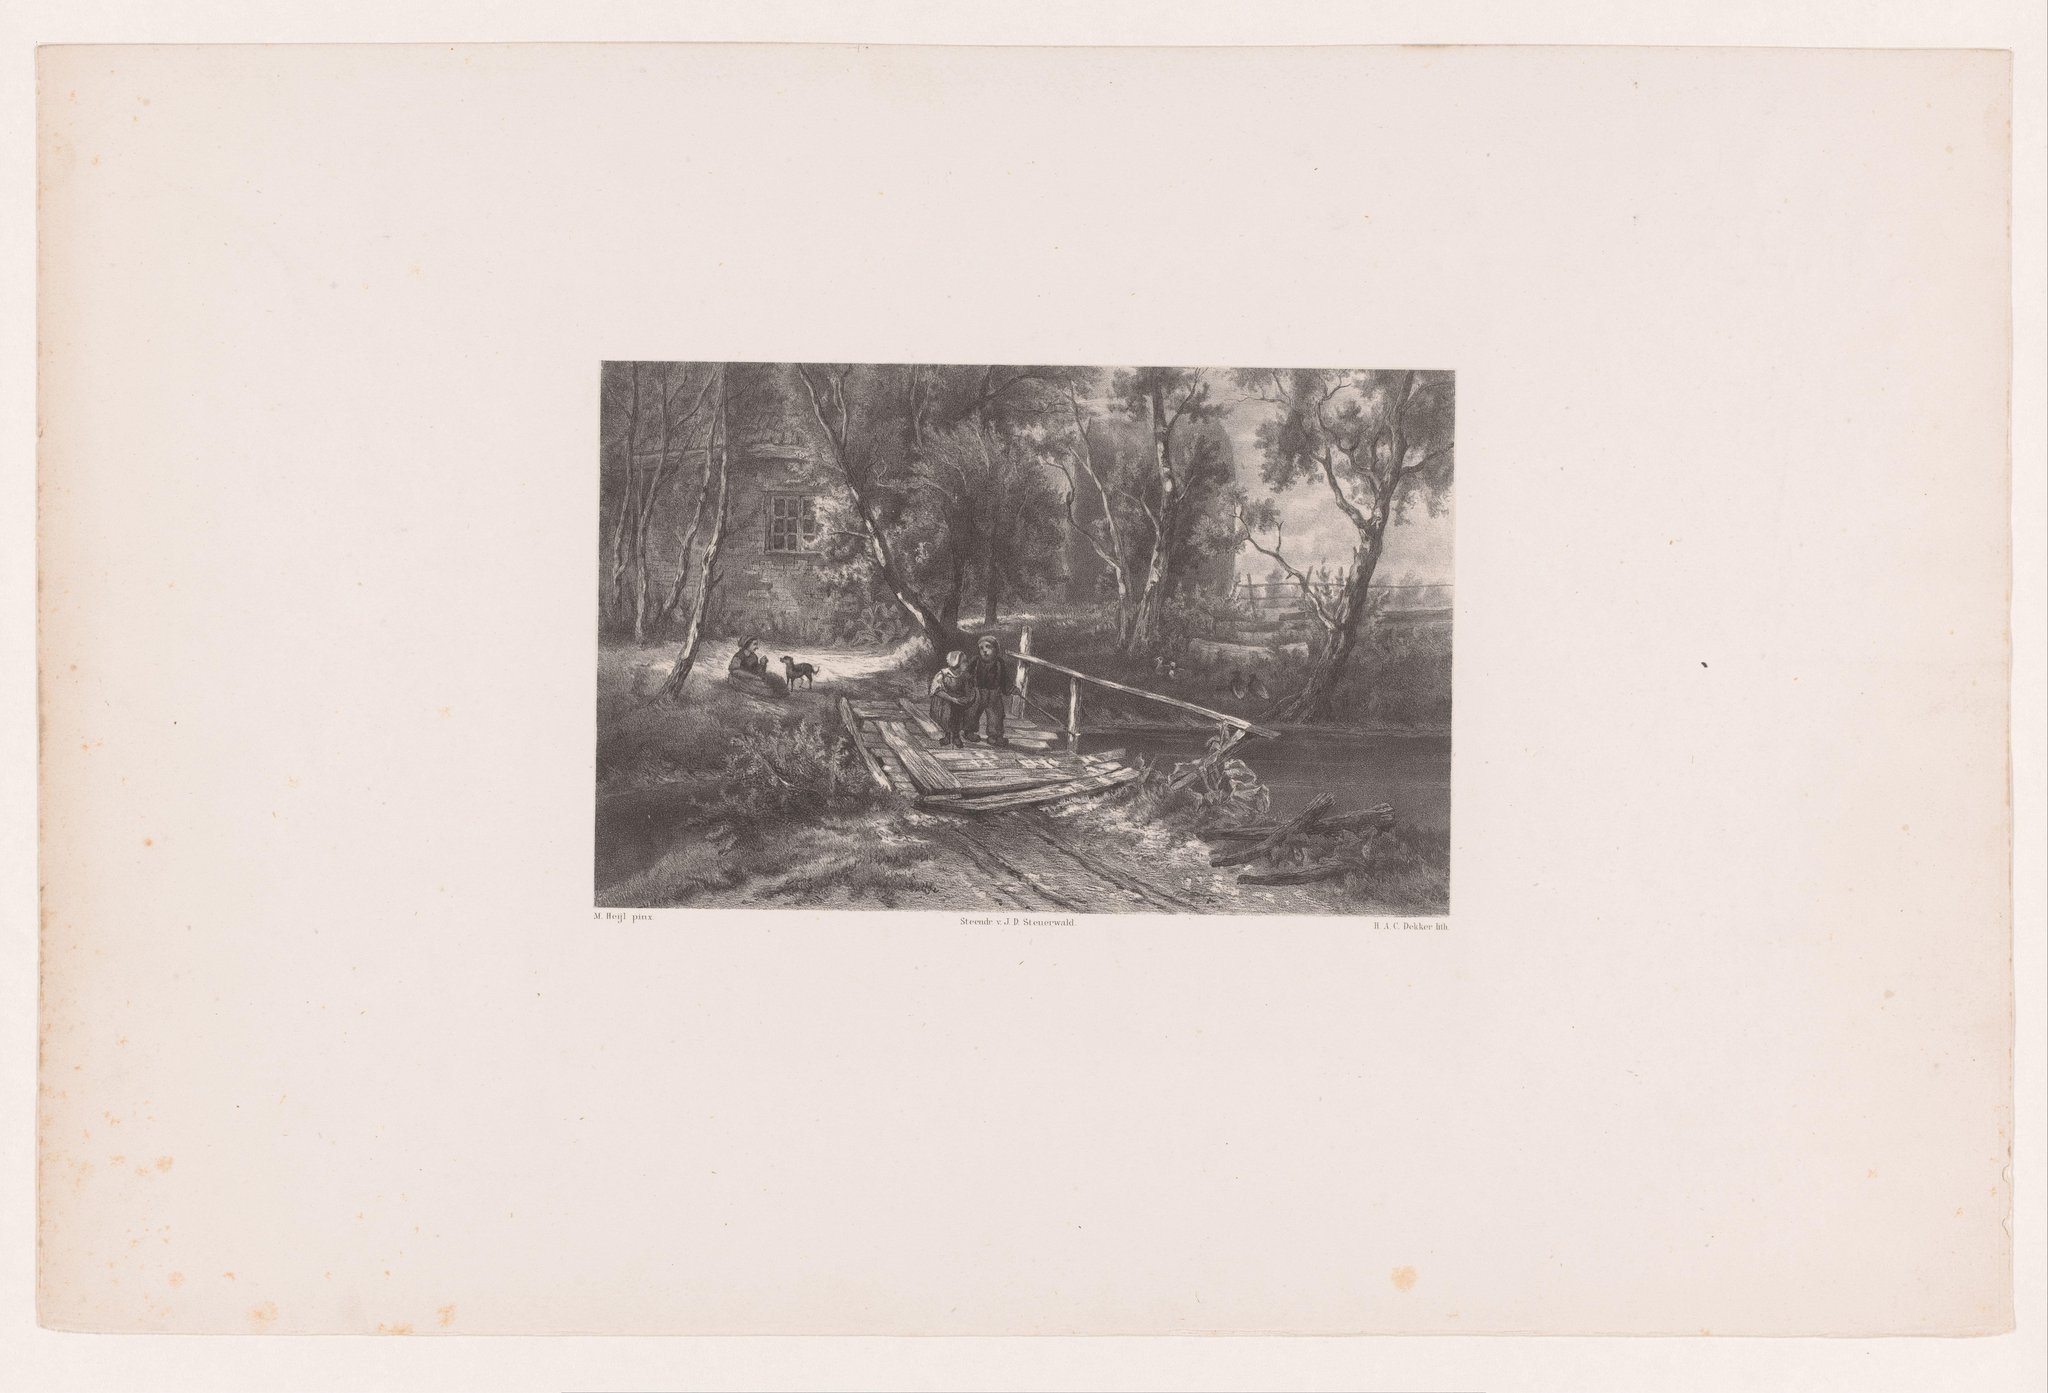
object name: print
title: Twee kinderen op een brug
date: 1846-1863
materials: paper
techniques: lithograph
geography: amsterdam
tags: landscape with bridge, viaduct or aqueduct, farm (building)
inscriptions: collector's mark: Lugt 2228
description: De jongen heeft een stok in zijn hand. Achter hen ligt een boerenwoning, daarvoor zit een vrouw met een hond.